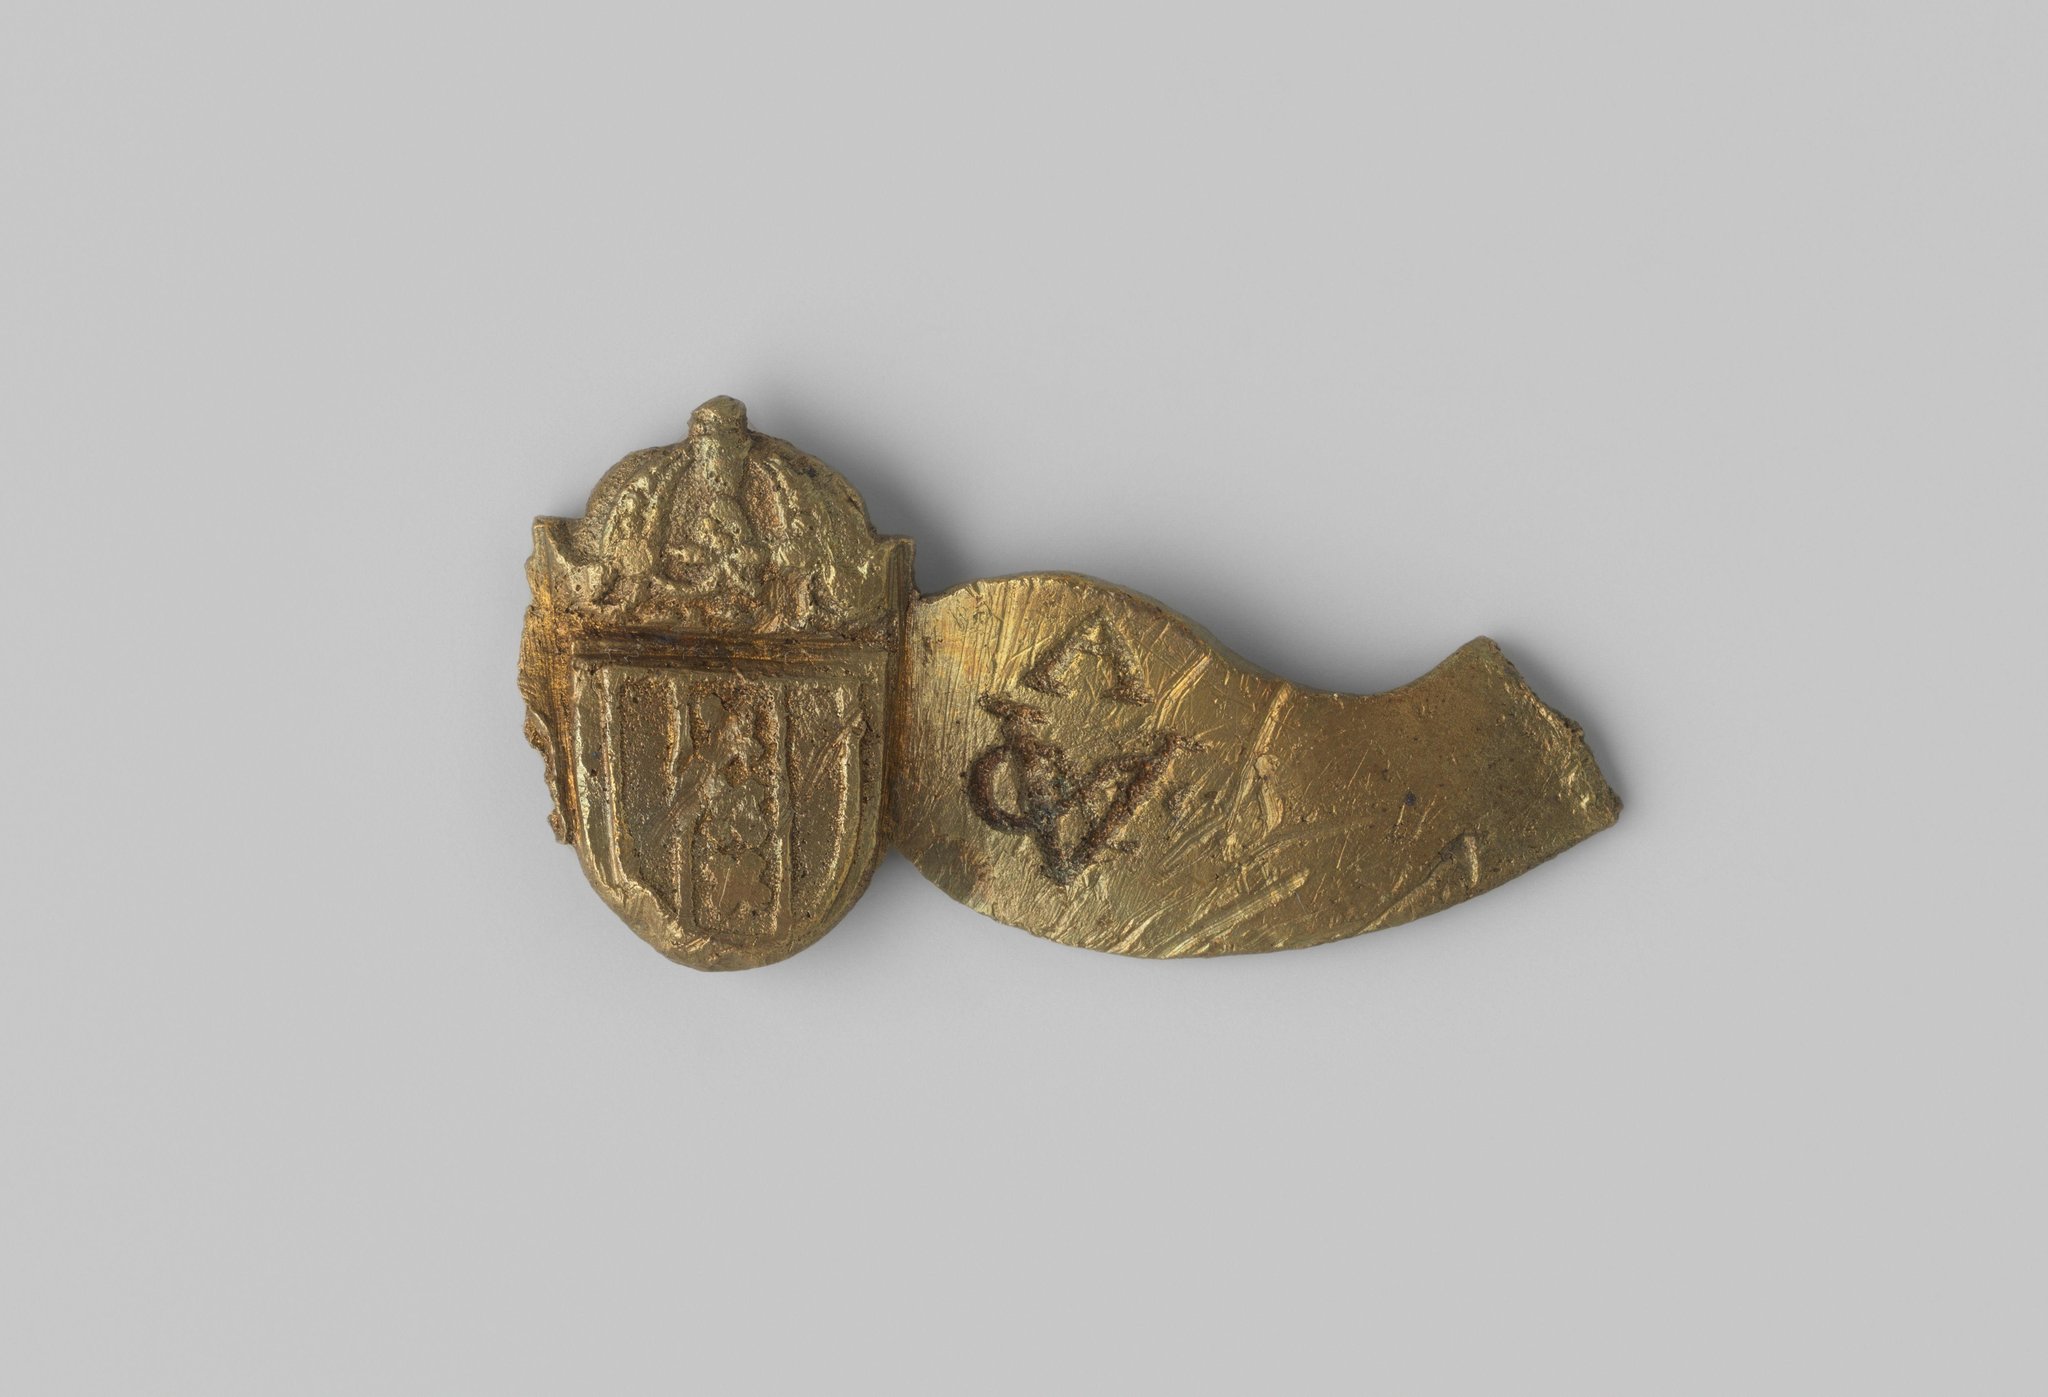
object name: schroefplaat, schroefblik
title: Fragment schroefplaat van een musket uit het wrak van de Oost-Indiëvaarder Hollandia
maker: Anonymous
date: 1700-1743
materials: copper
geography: netherlands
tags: verenigde oostindische compagnie, hollandia (schip), annet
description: Fragm, id. NG 1978-74H986 or NG 1980-27H3069, left wing and right eye broken off, side plate.